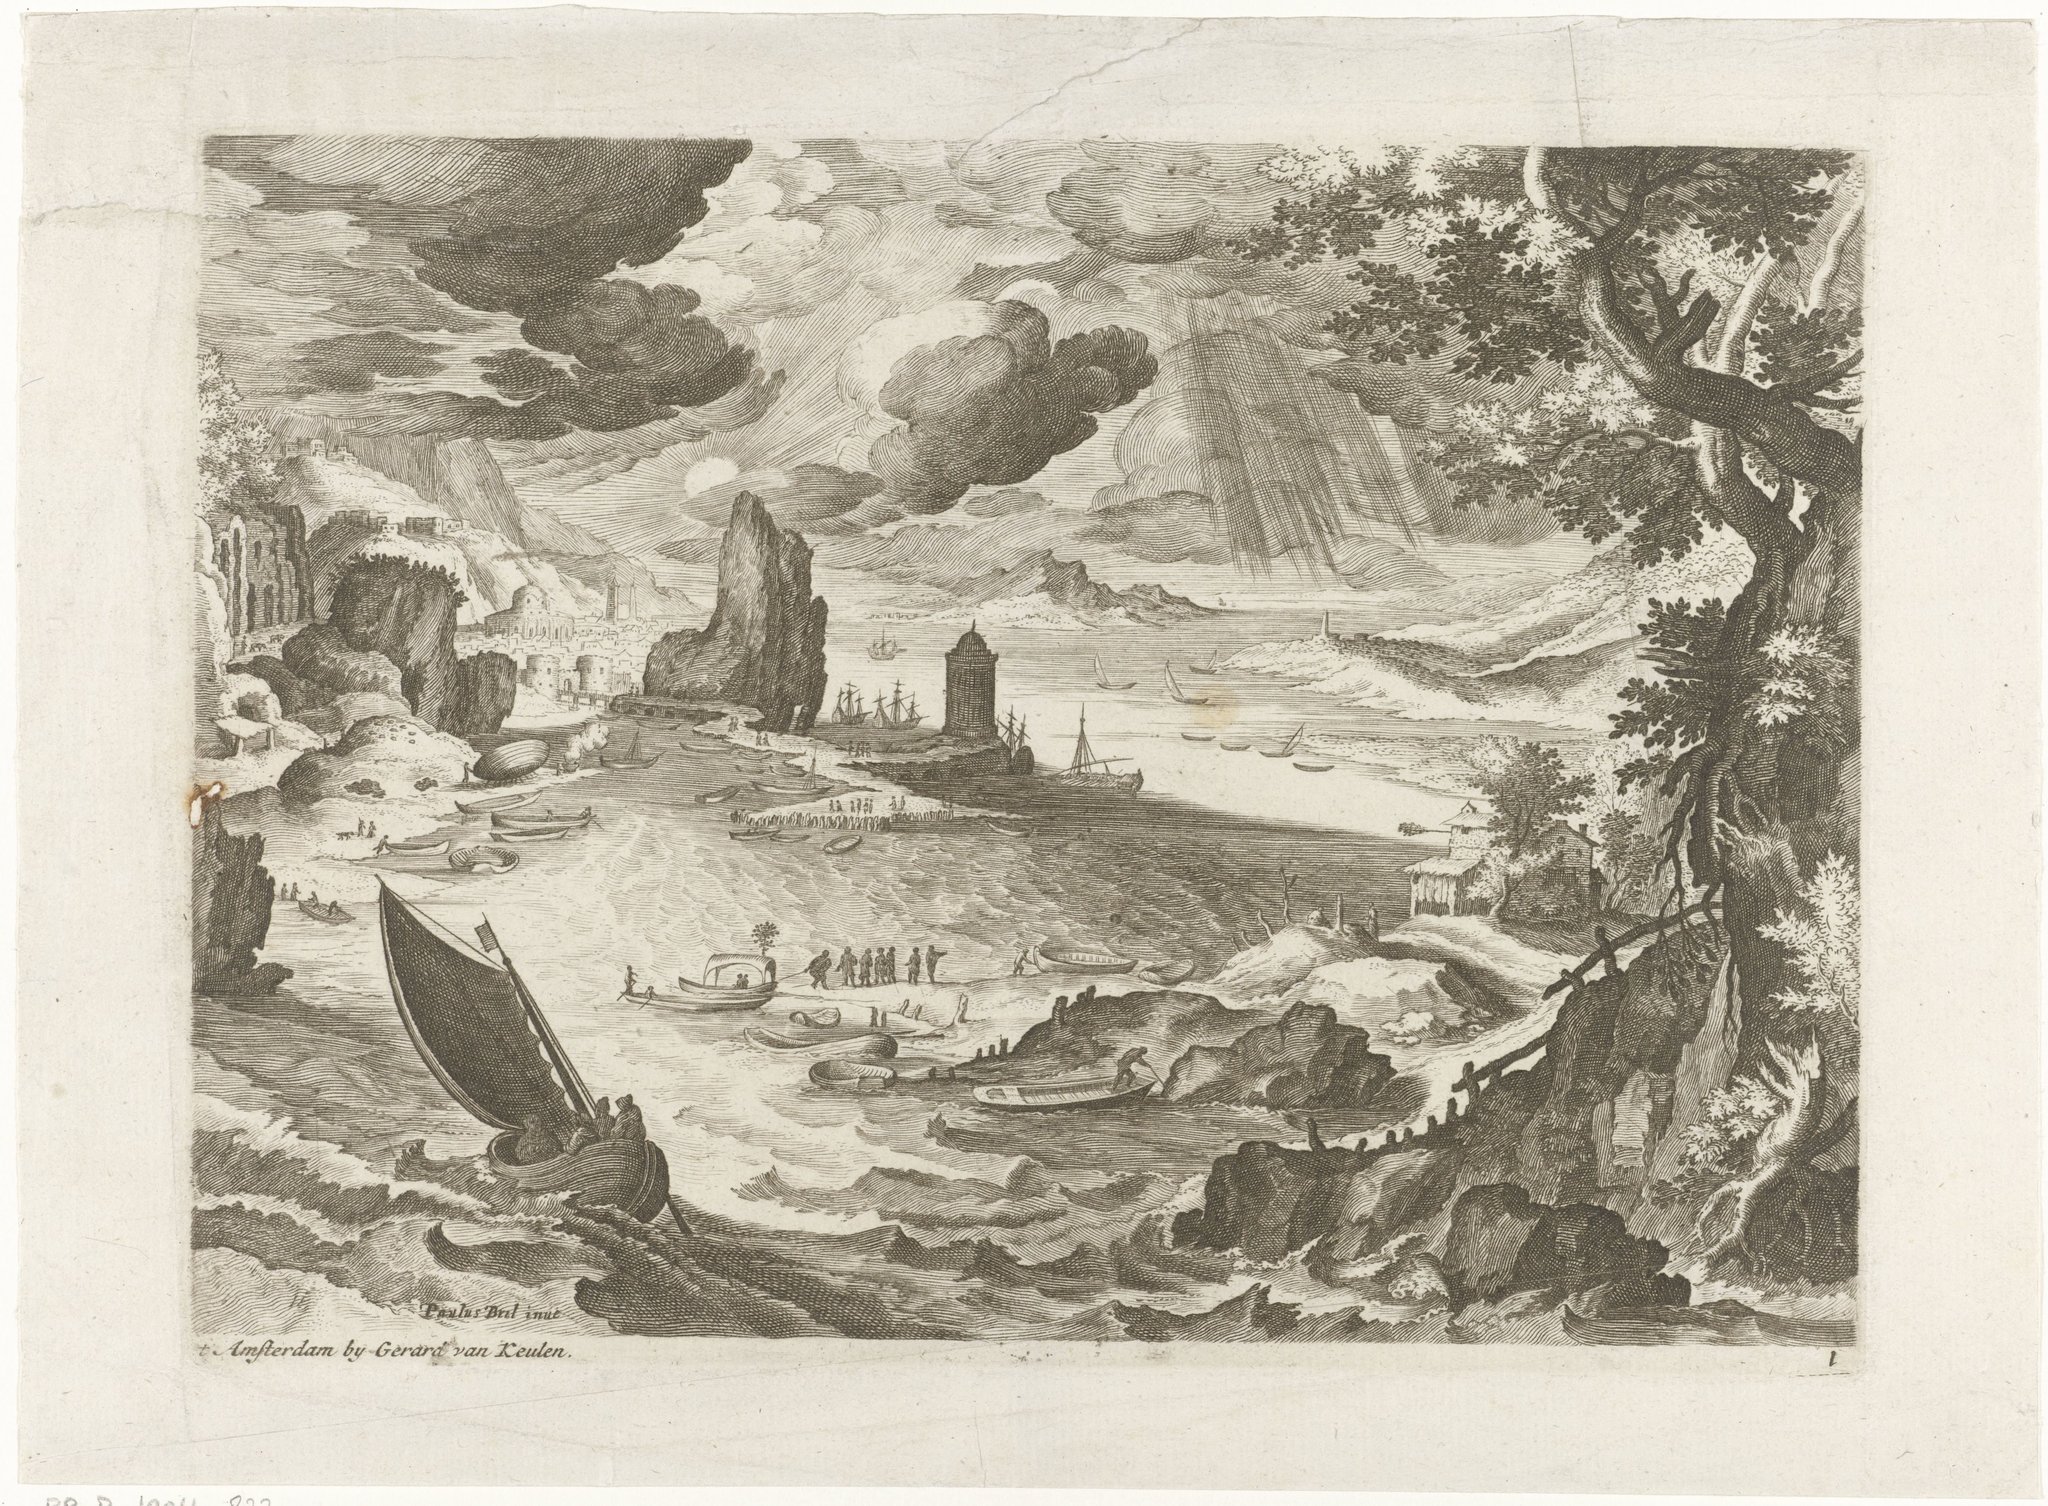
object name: print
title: Kustlandschap met zeilschip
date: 1688-1727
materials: paper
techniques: engraving, etching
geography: amsterdam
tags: harbour, rocky coast (+ landscape with figures, staffage), sailing-ship, sailing-boat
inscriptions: collector's mark: Lugt 2228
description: Kustlandschap met op de voorgrond een zeilschip die richting een haven vaart.